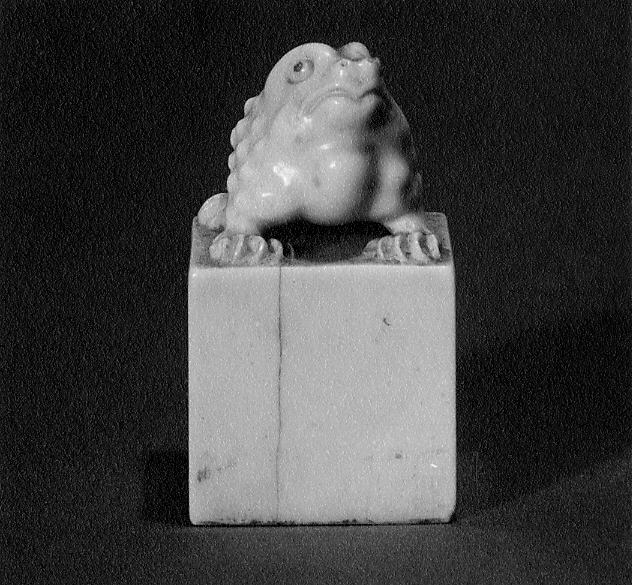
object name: seal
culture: chinese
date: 1701-1800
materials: ivory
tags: frogs